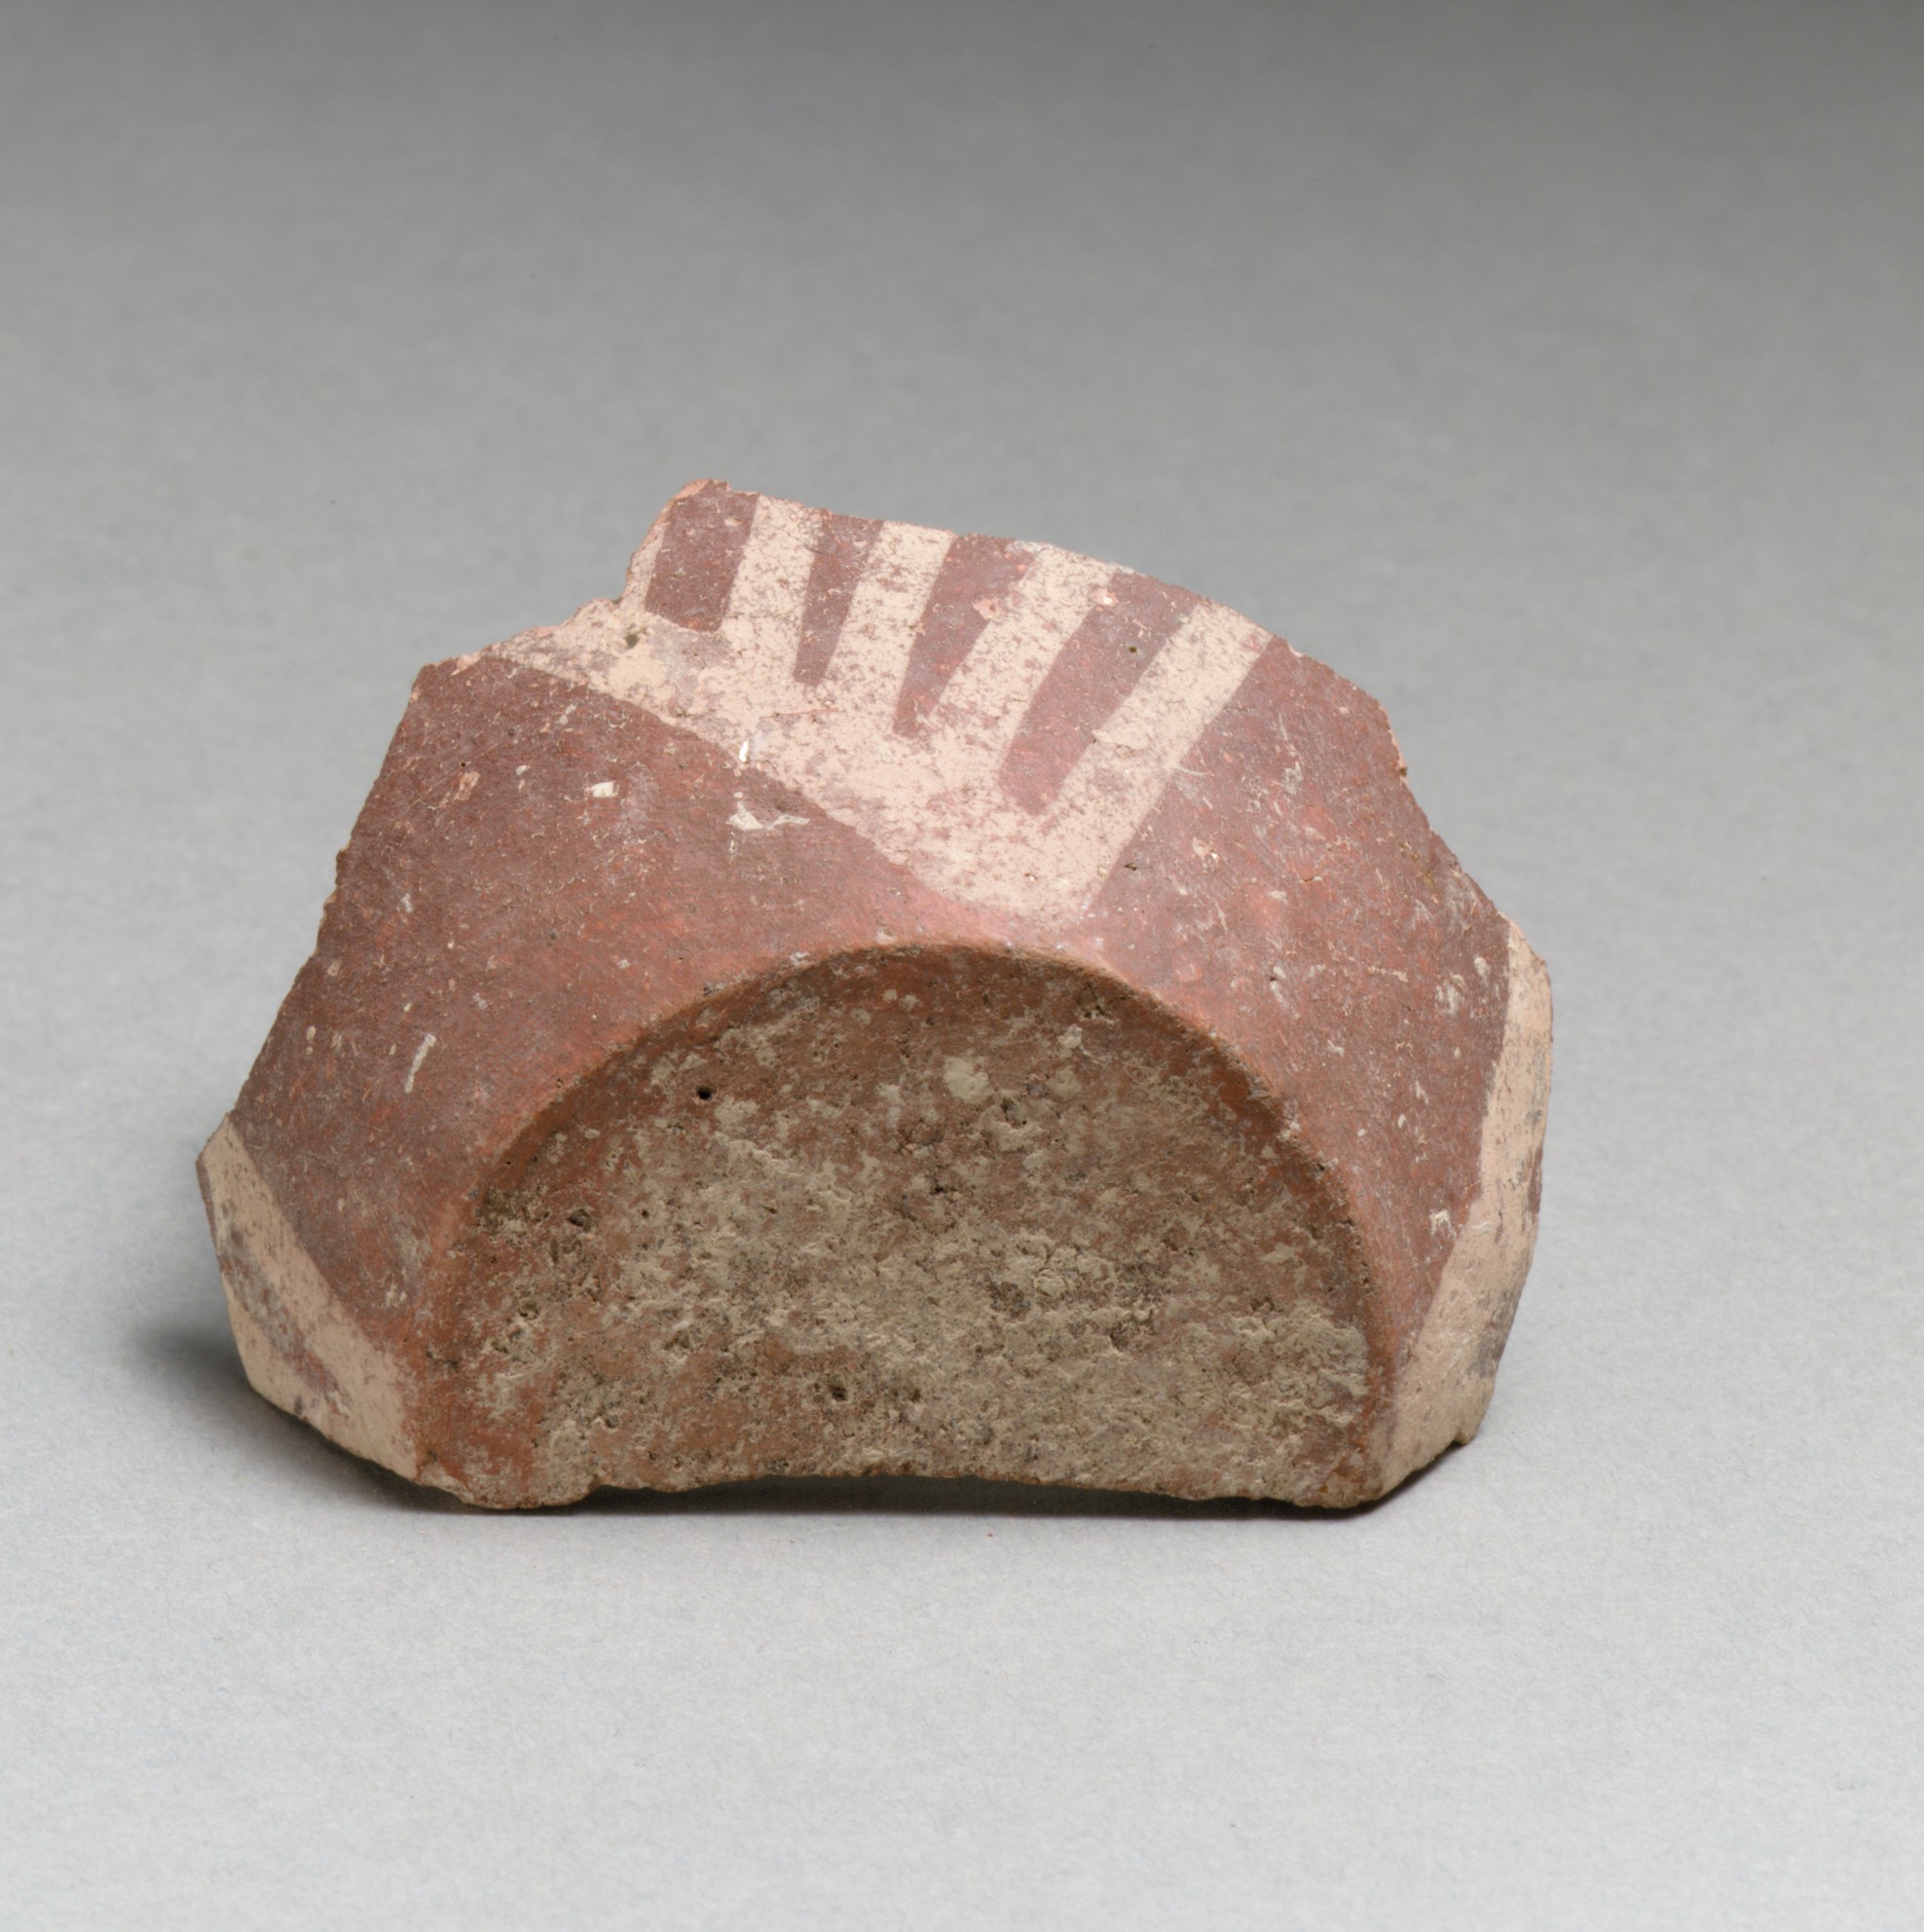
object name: vase fragment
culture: minoan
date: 2600-2000 BCE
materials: terracotta